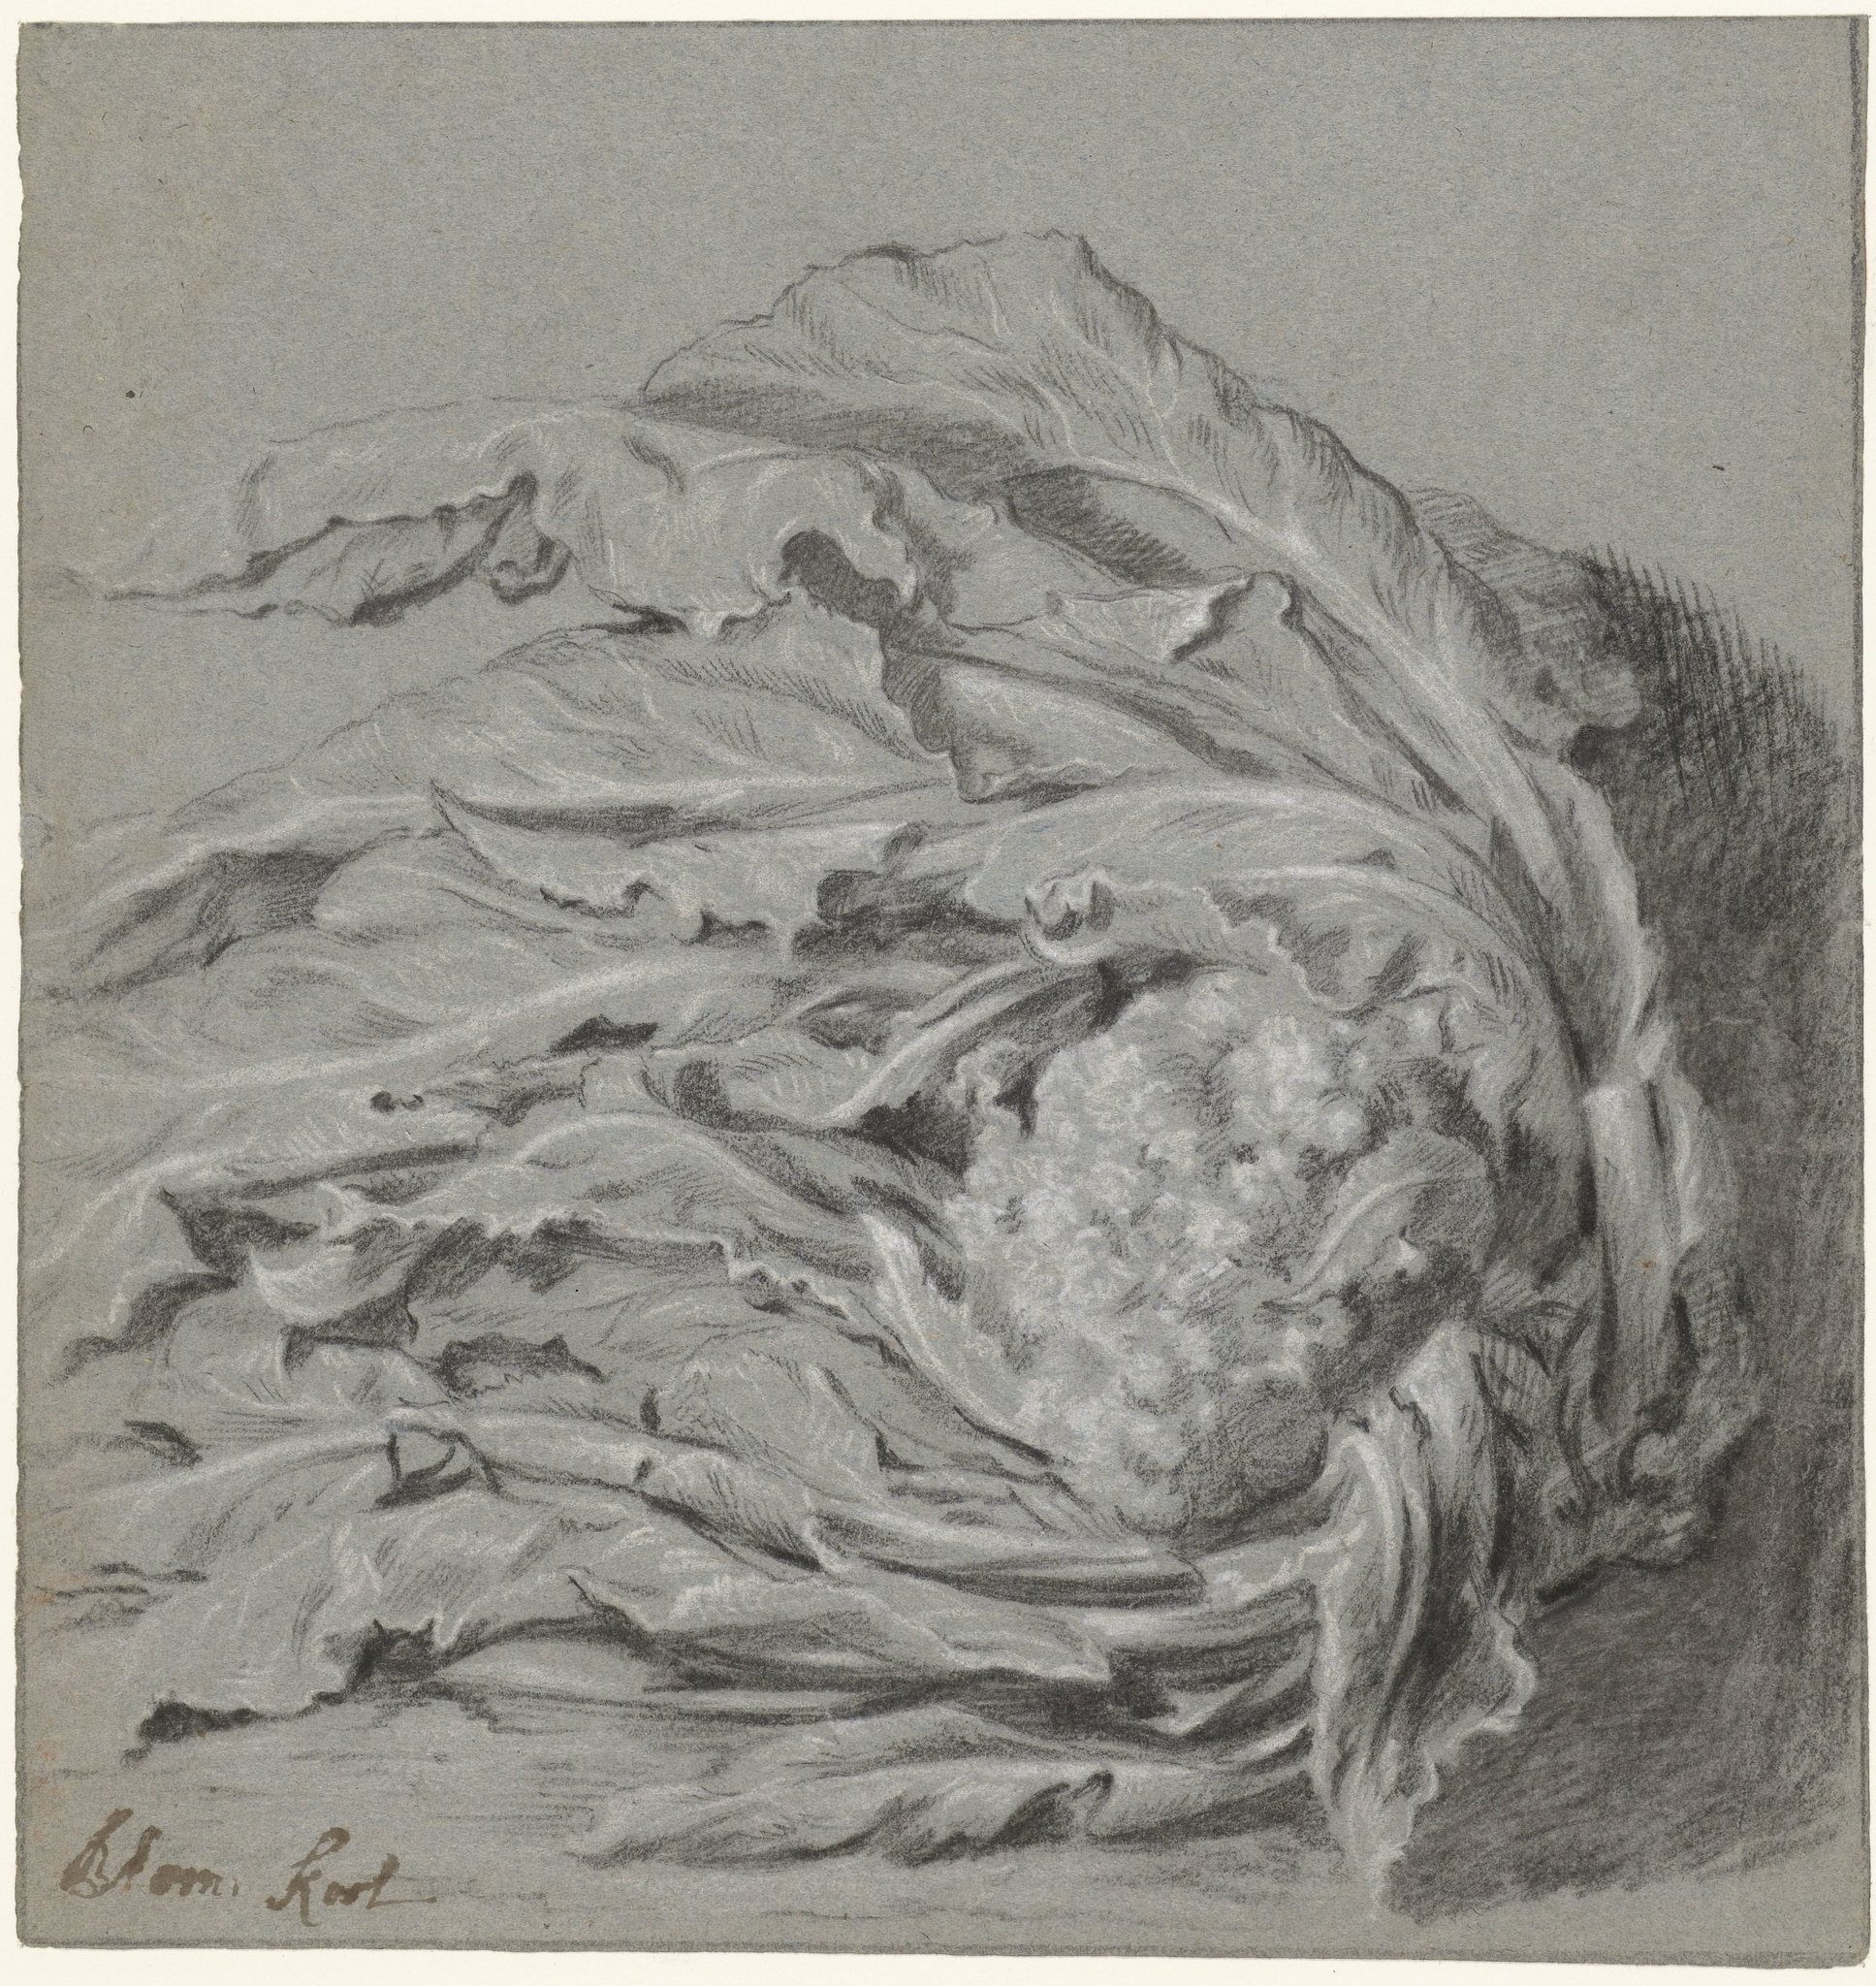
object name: drawing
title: Bloemkool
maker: Anonymous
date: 1600-1699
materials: chalk, paper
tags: (non-fruit) products of plants or trees: cauliflower, vegetables (with name)